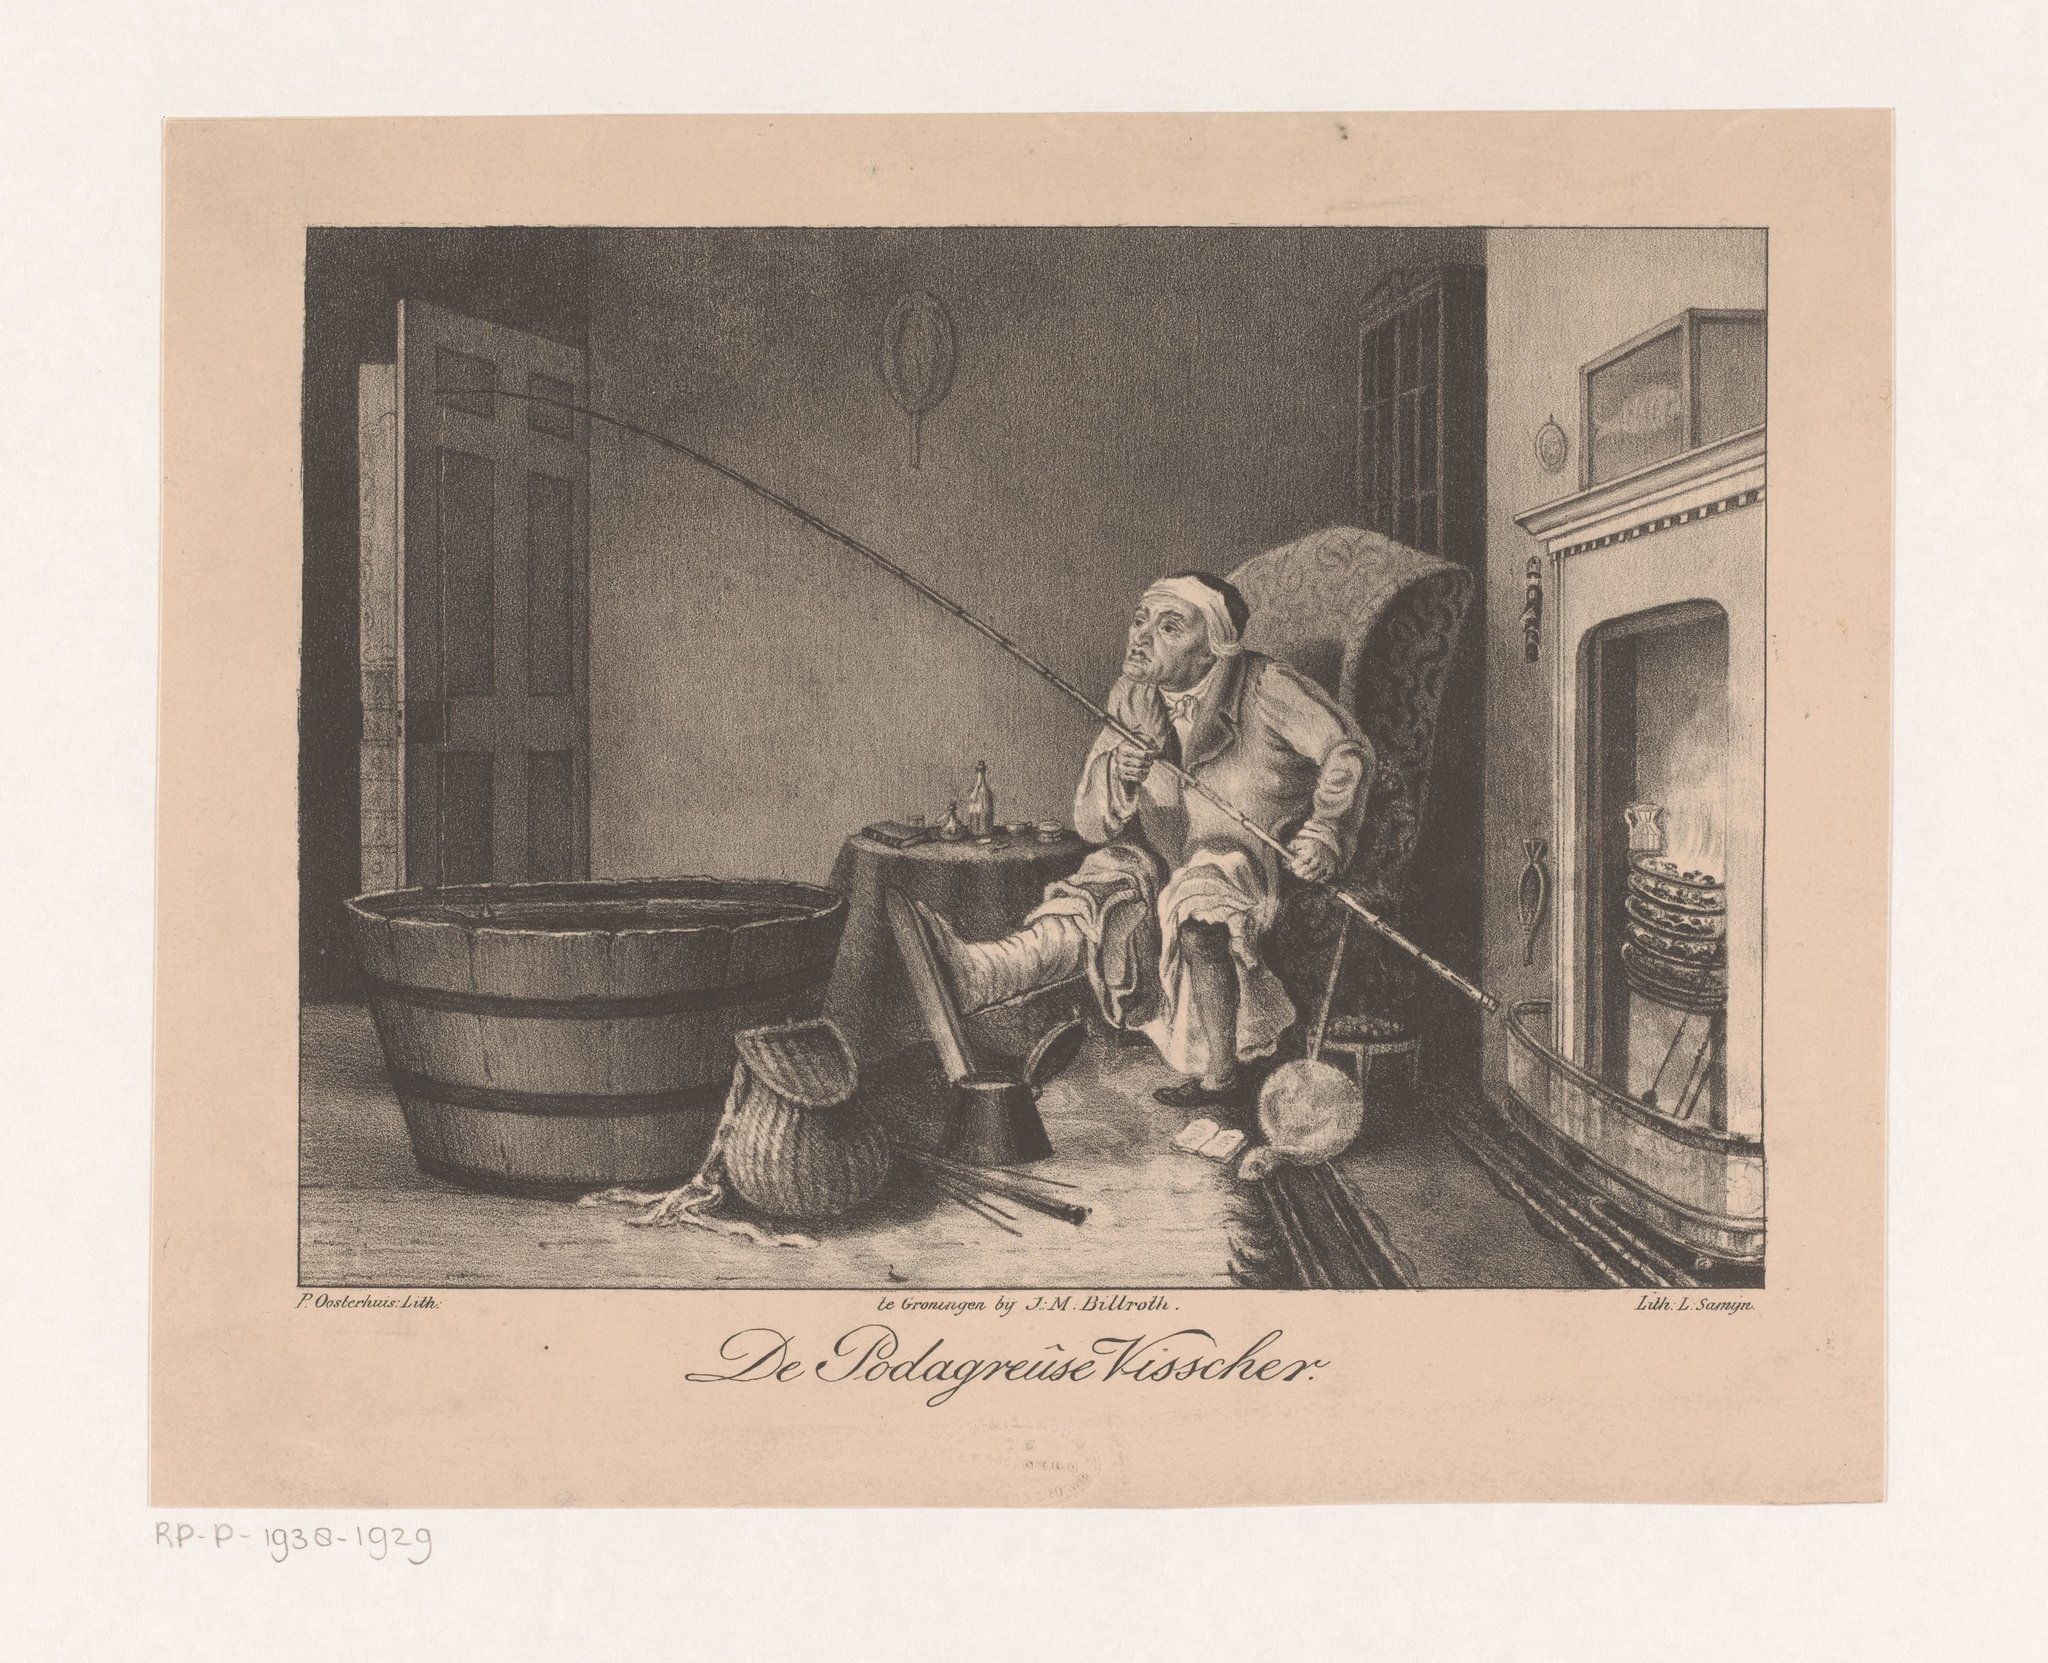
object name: print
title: Hengelende man met voetjicht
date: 1834-1835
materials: paper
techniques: lithograph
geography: groningen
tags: disabilities, deformations, fishing (sports)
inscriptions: check stamp, collector's mark: Lugt 2228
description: Een man met voetjicht (podagra) zit met ingezwachteld been op een stoel bij een haard. In zijn handen houdt hij een hengel waarmee hij in de ton met water voor hem vist. Links een open deur.